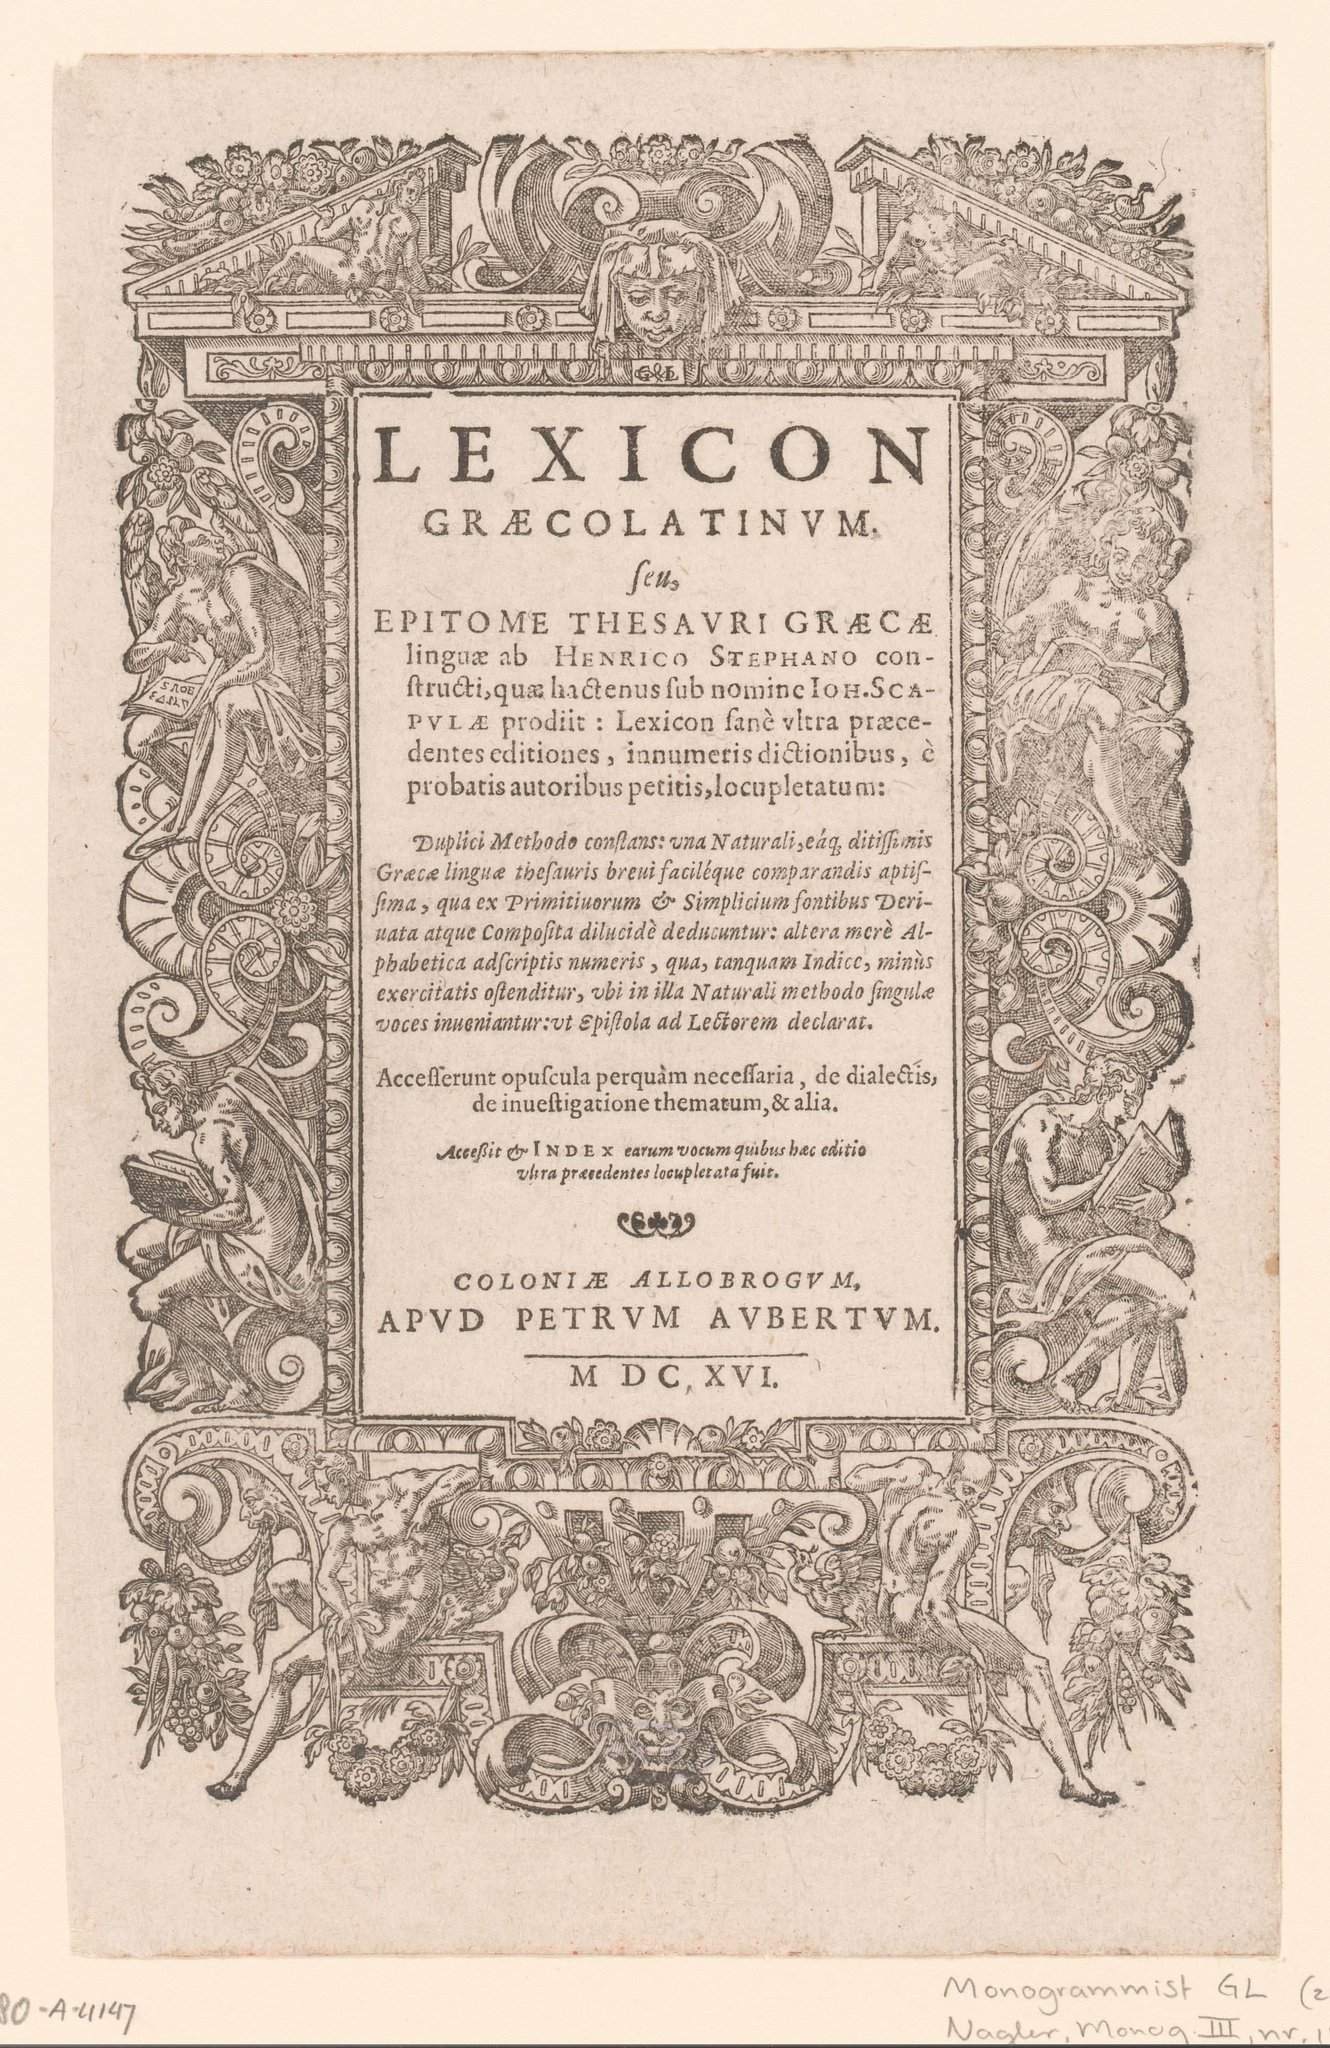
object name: print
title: Ornamentele lijst met schrijvende mensen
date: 1616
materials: paper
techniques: letterpress printing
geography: geneva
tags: anthropomorphic ornament, title-page, author, poet writing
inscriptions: collector's mark: Lugt 2228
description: Titelpagina voor: Estienne, Henri. Lexicon Graecolatium (...). Genève: Petrus Aubert, 1616.